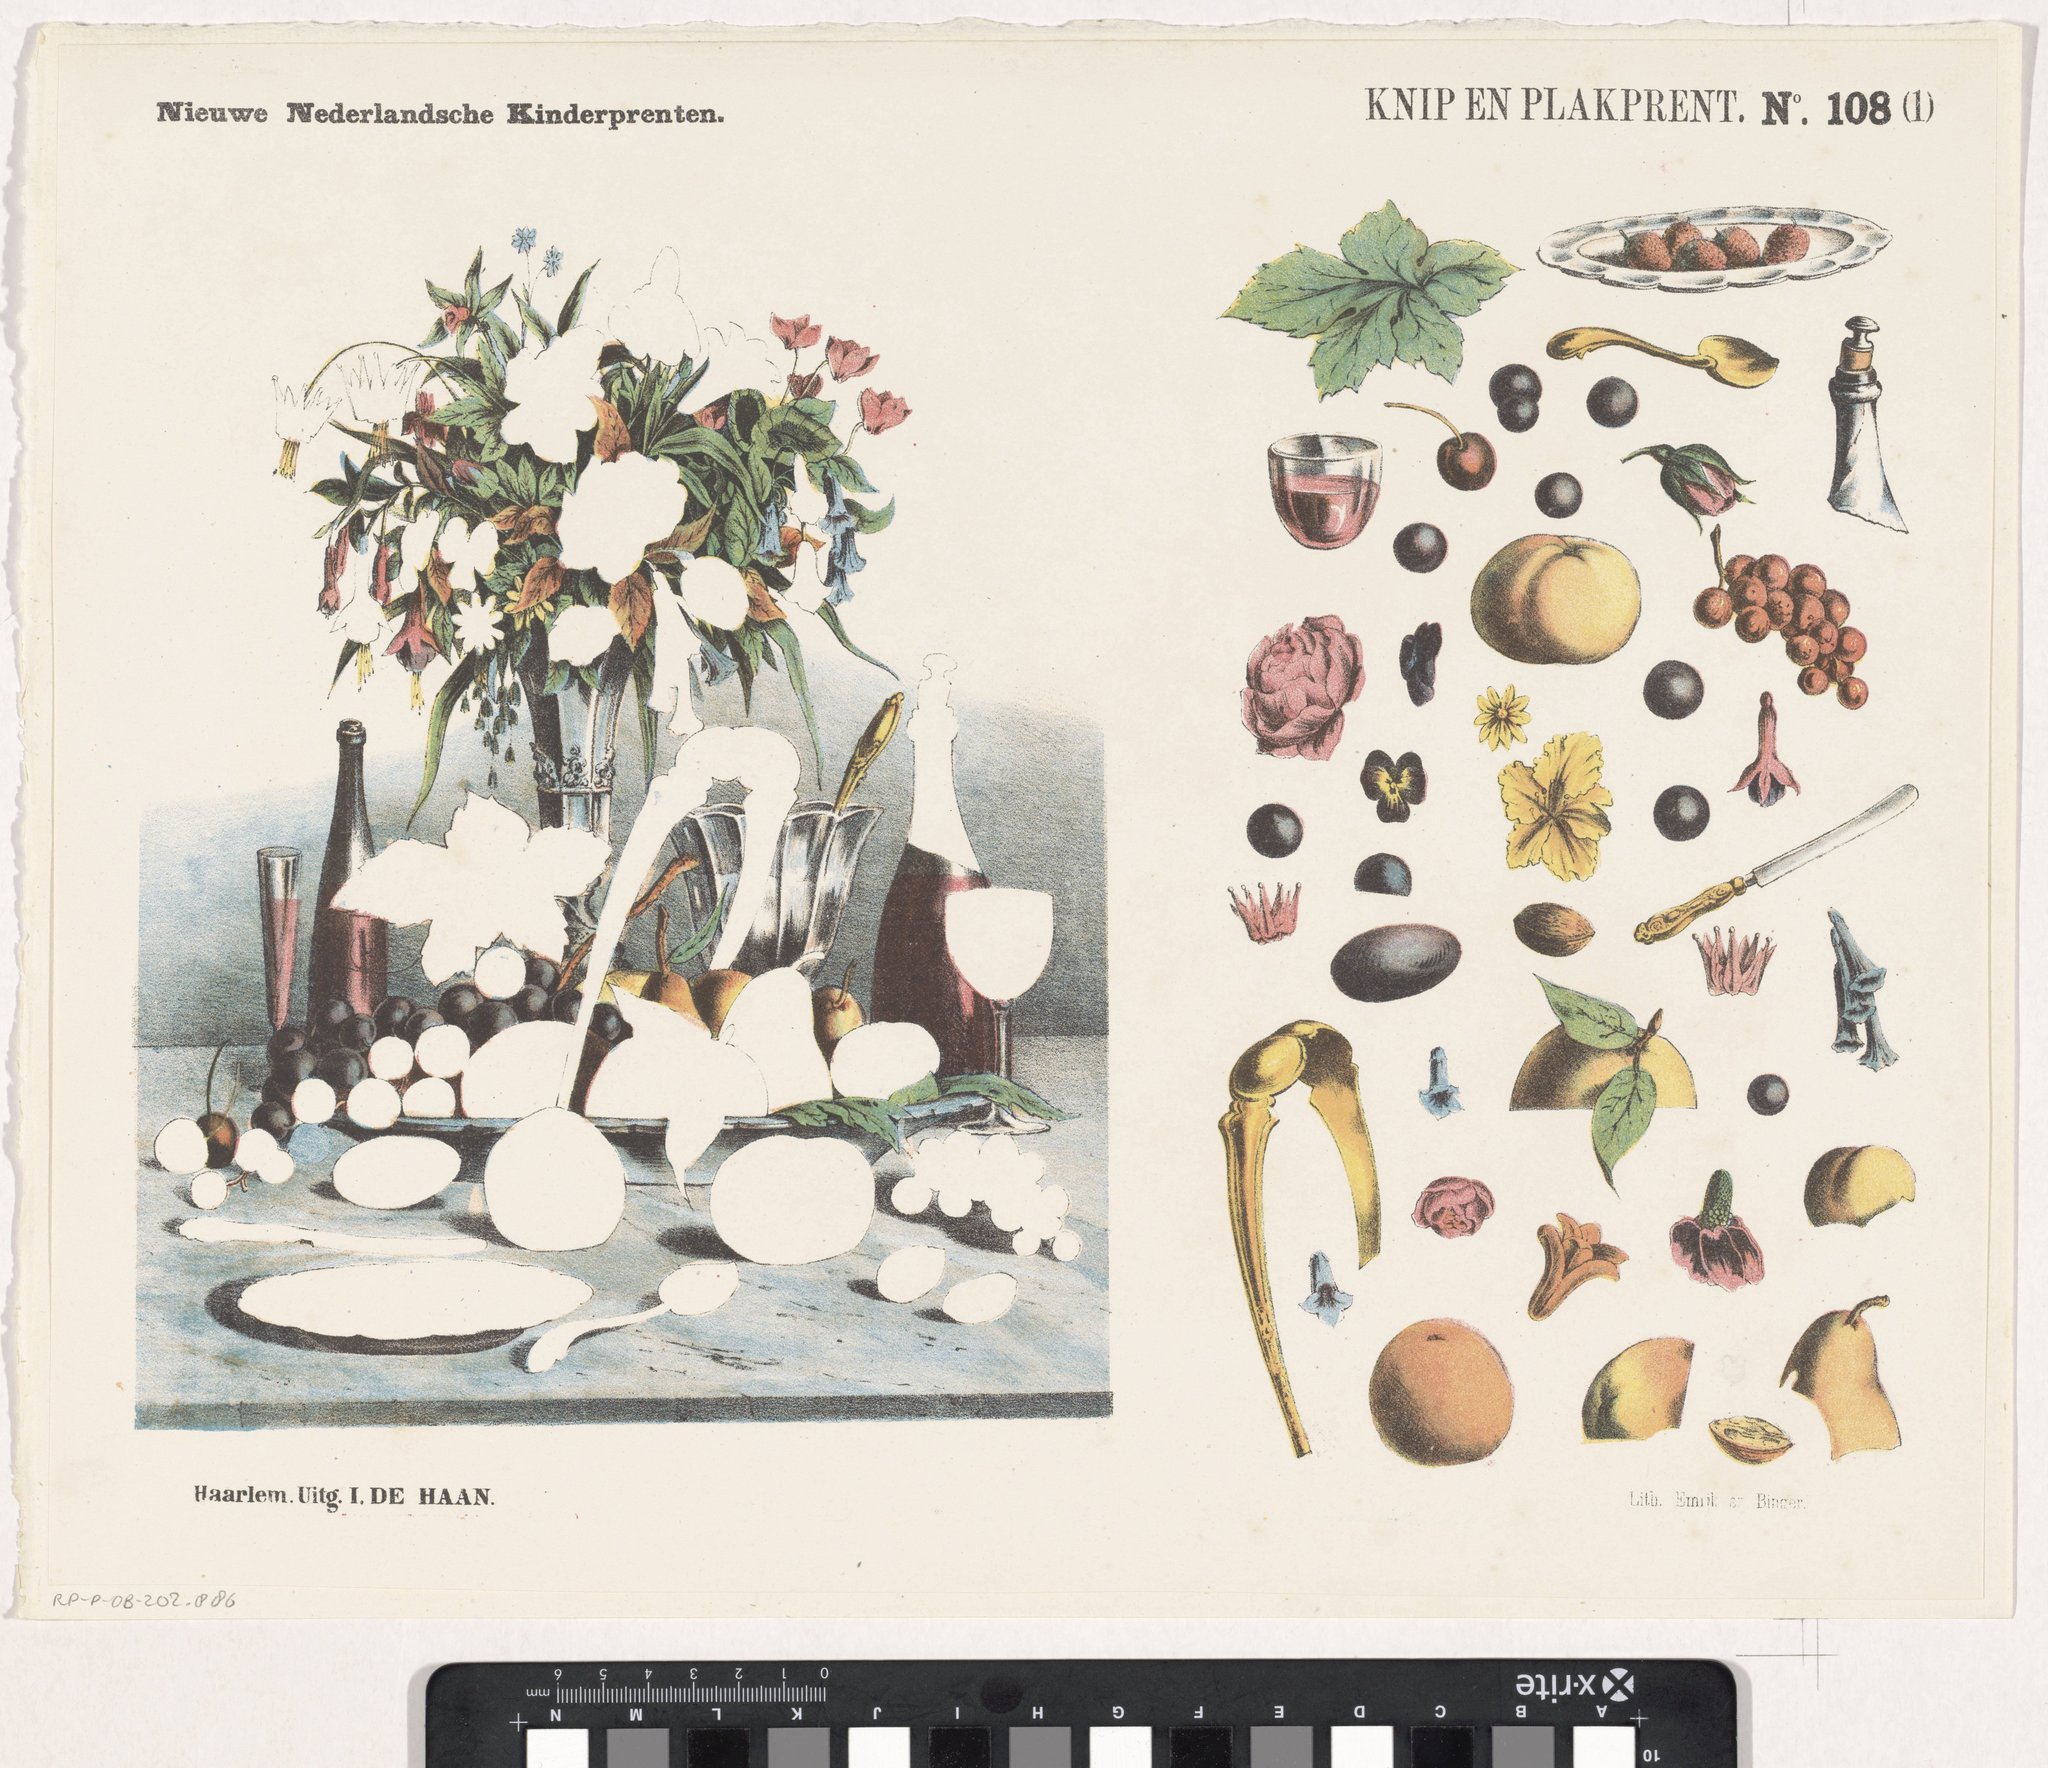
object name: popular print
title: Nieuwe Nederlandsche kinderprenten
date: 1875-1903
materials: paper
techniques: lithograph, letterpress printing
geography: haarlem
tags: laid table as still life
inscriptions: collector's mark: Lugt 2760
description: Blad met links een voorstelling van een gedekte tafel met een fruitschaal en een vaas met bloemen. In de voorstelling zijn plekken wit gelaten. Rechts de bijbehorende uit te knippen en op de witte plekken te plakken voorwerpen. Genummerd rechtsboven: No. 108.